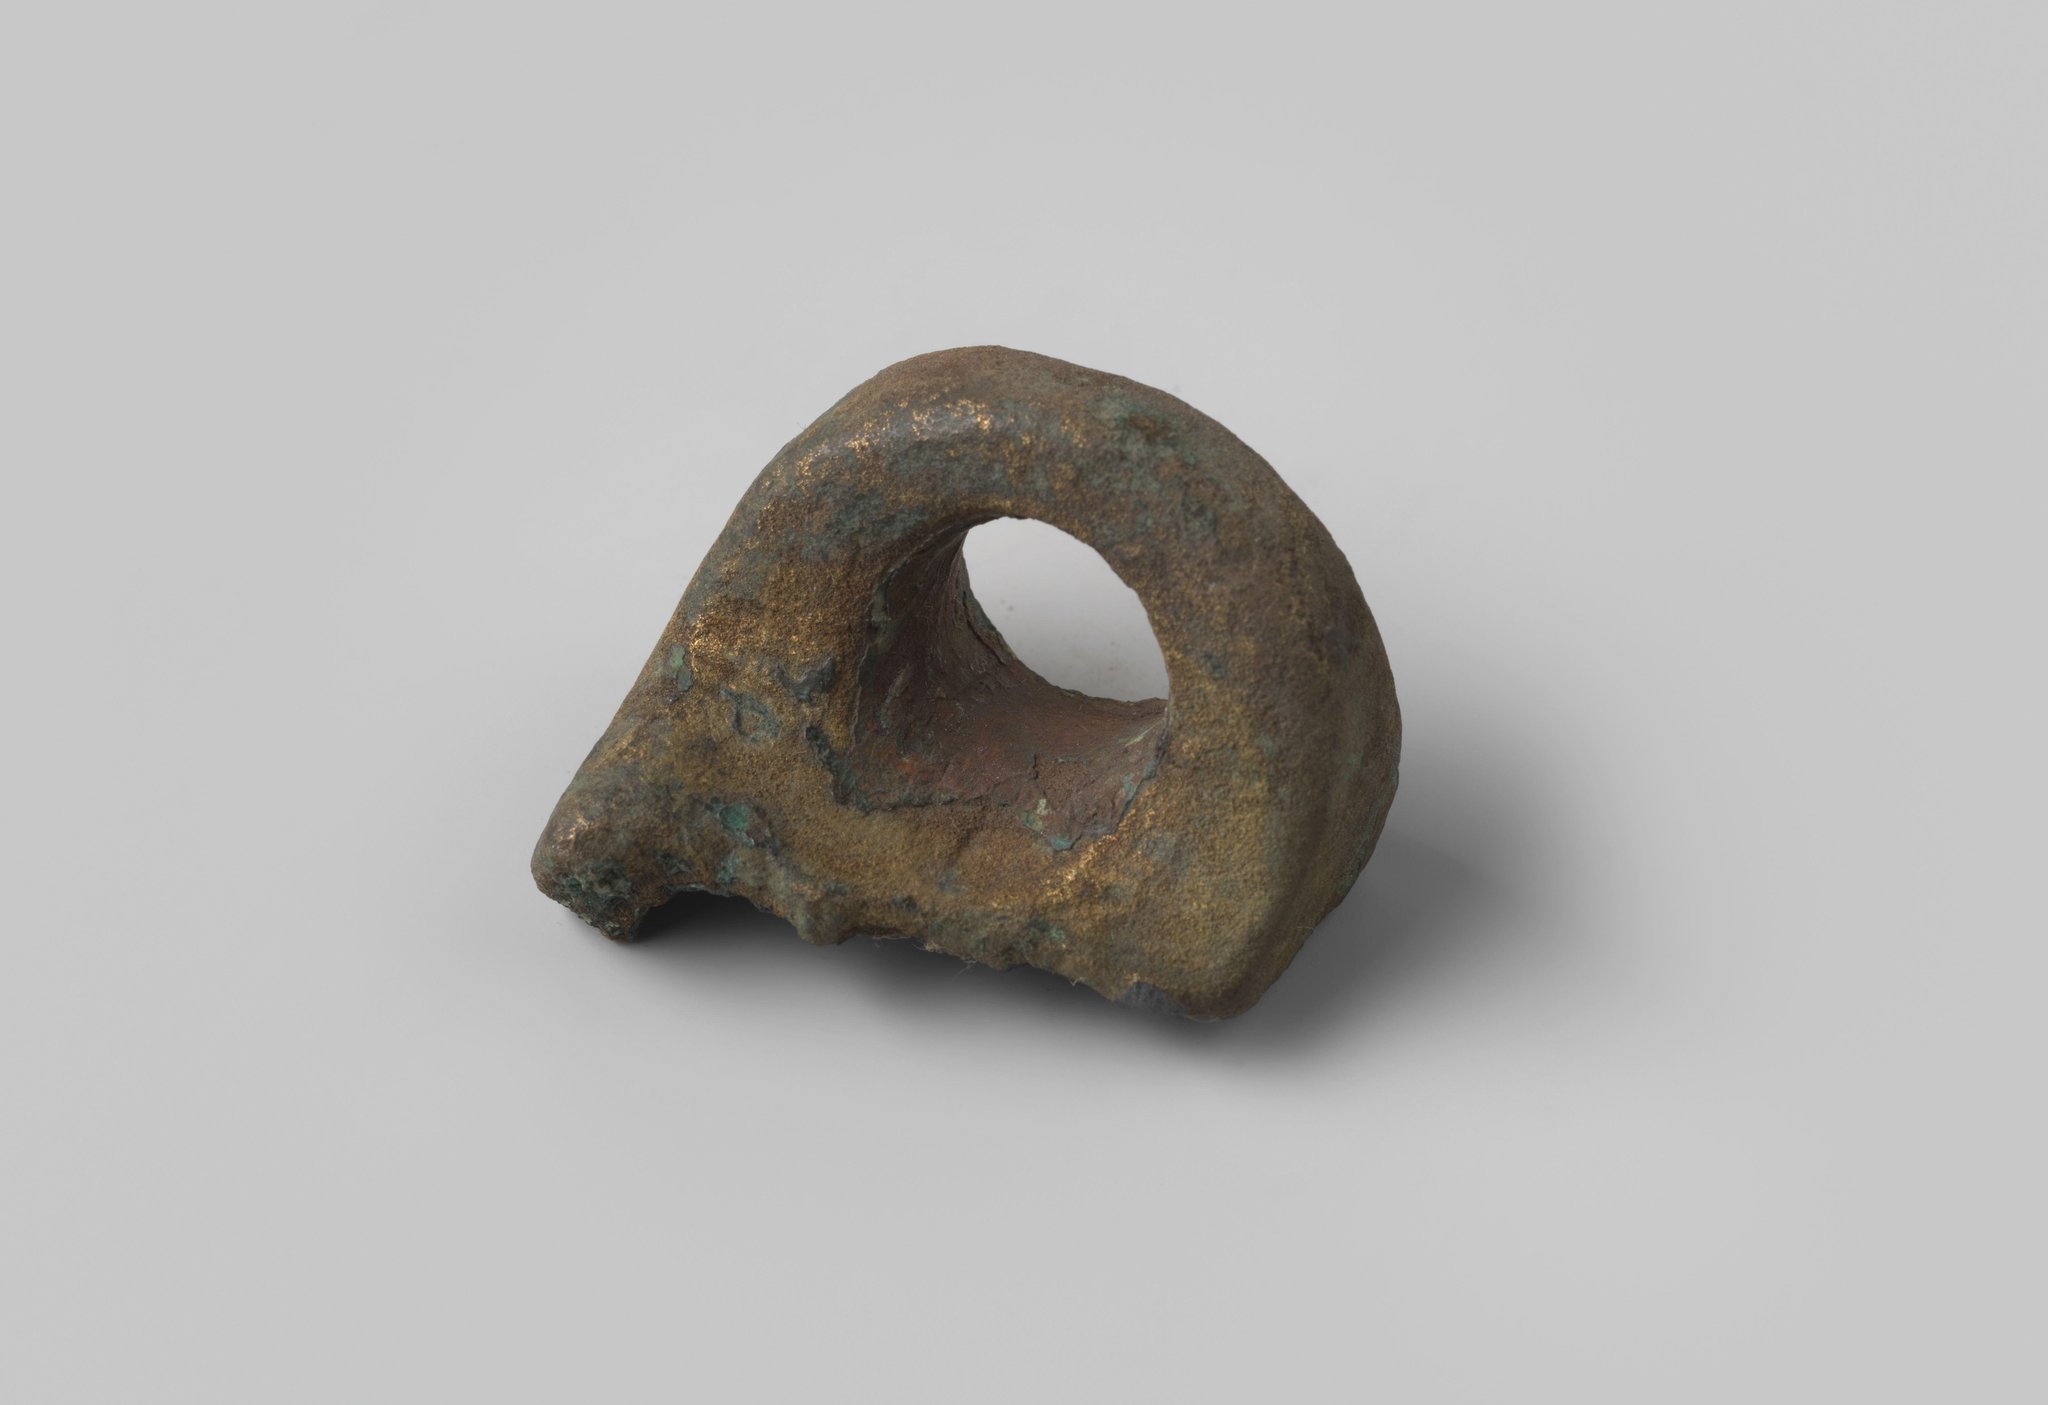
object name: firehose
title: Fragment koppelstuk van een brandslang uit het wrak van de Oost-Indiëvaarder Hollandia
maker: Anonymous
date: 1700-1743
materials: copper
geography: netherlands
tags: verenigde oostindische compagnie, hollandia (schip), annet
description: Fire engine, firehose coupling; fragment, loop id. NG 1978-29H649.